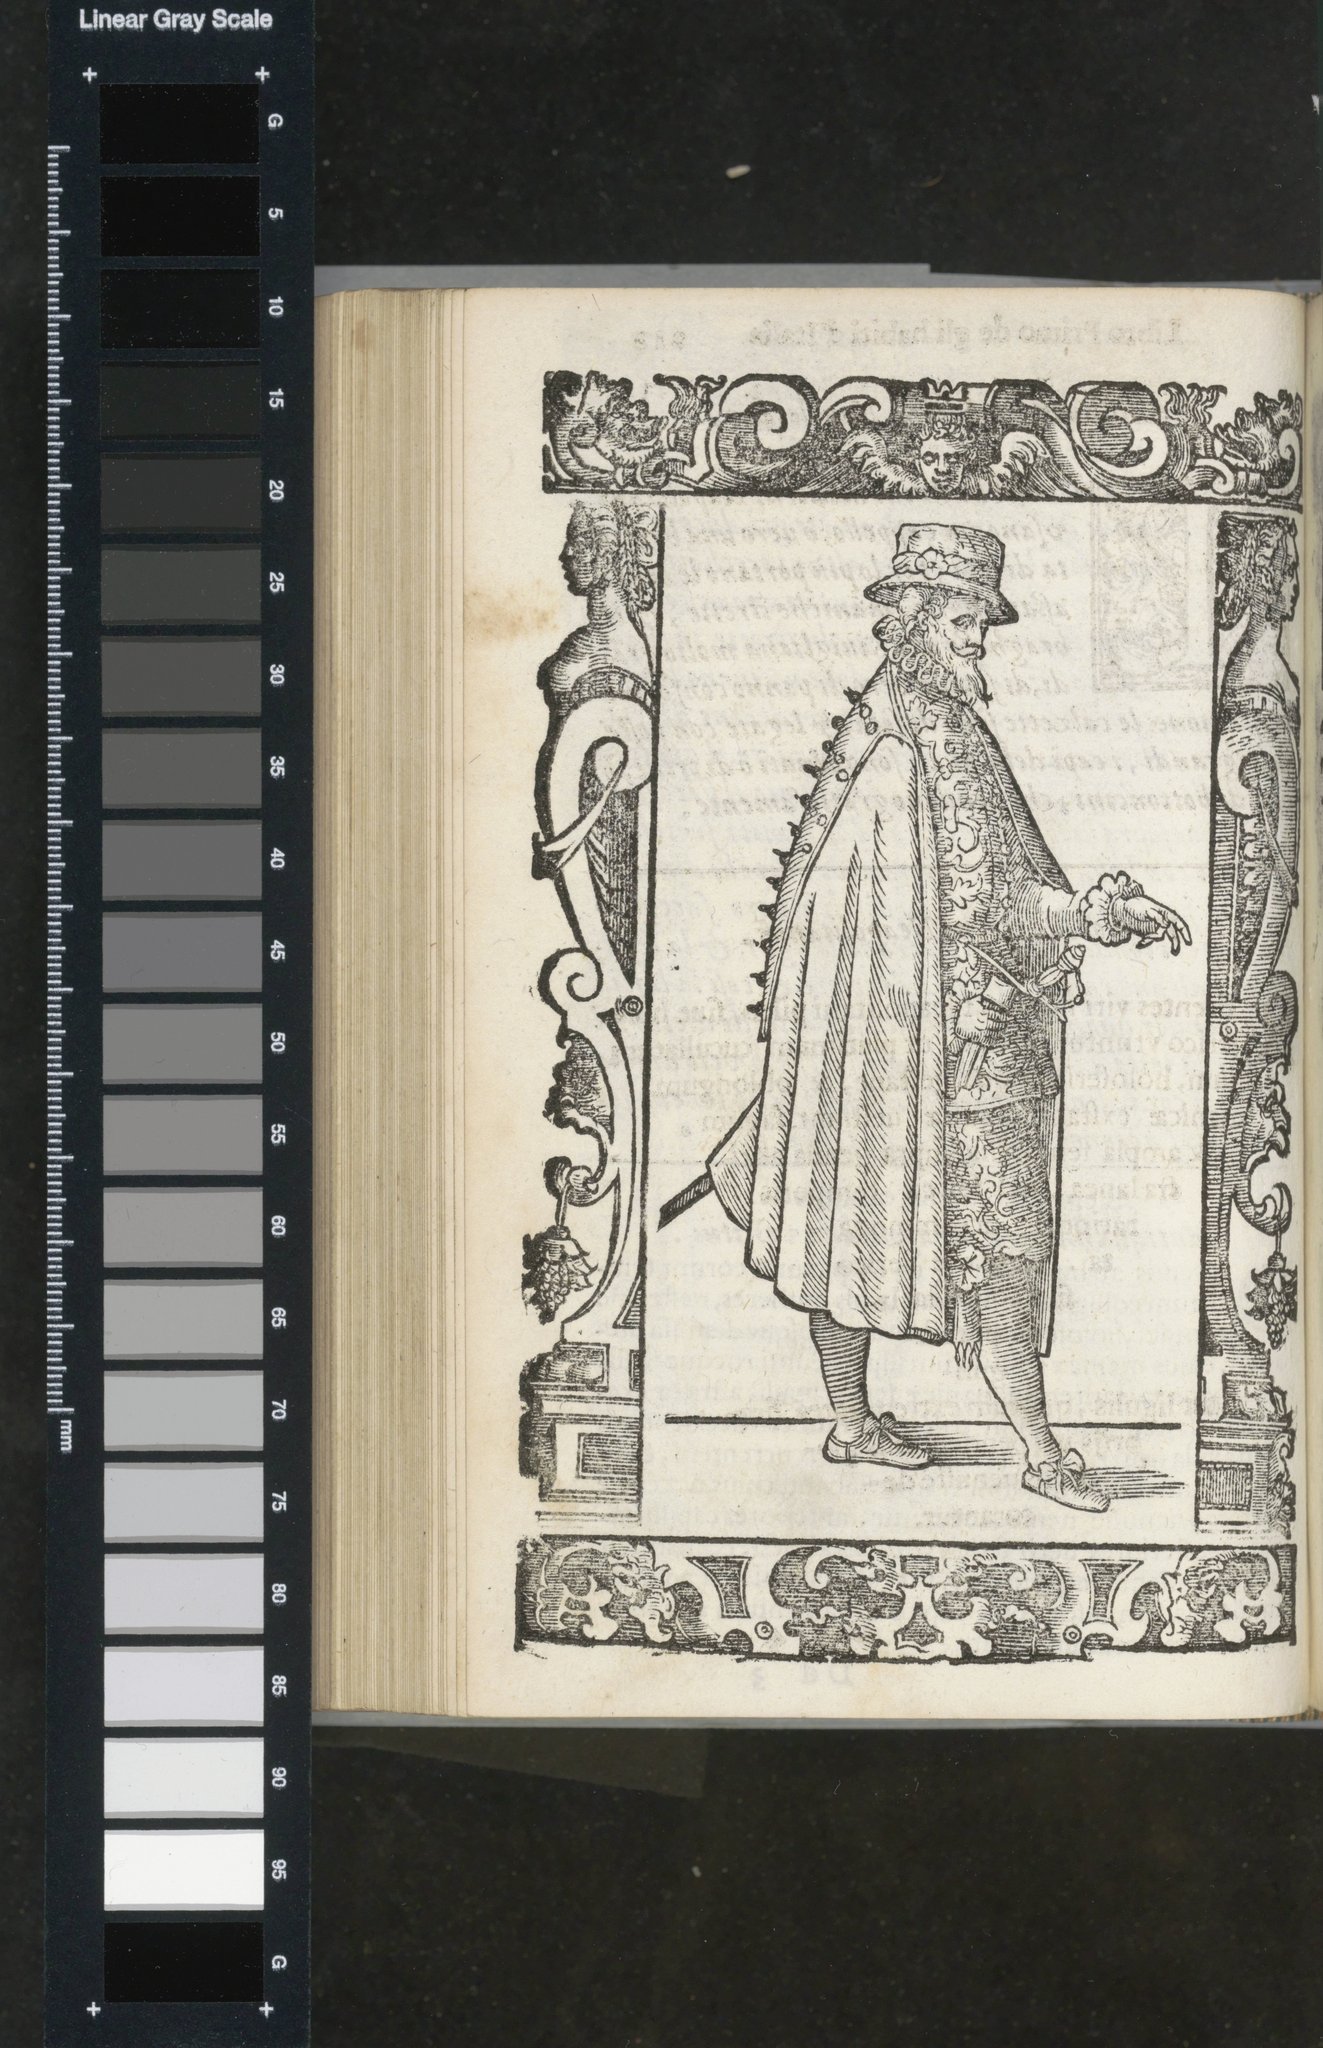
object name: costume print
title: Habiti antichi, et moderni di tutto il mondo...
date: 1598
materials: paper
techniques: woodcut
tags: fashion plates